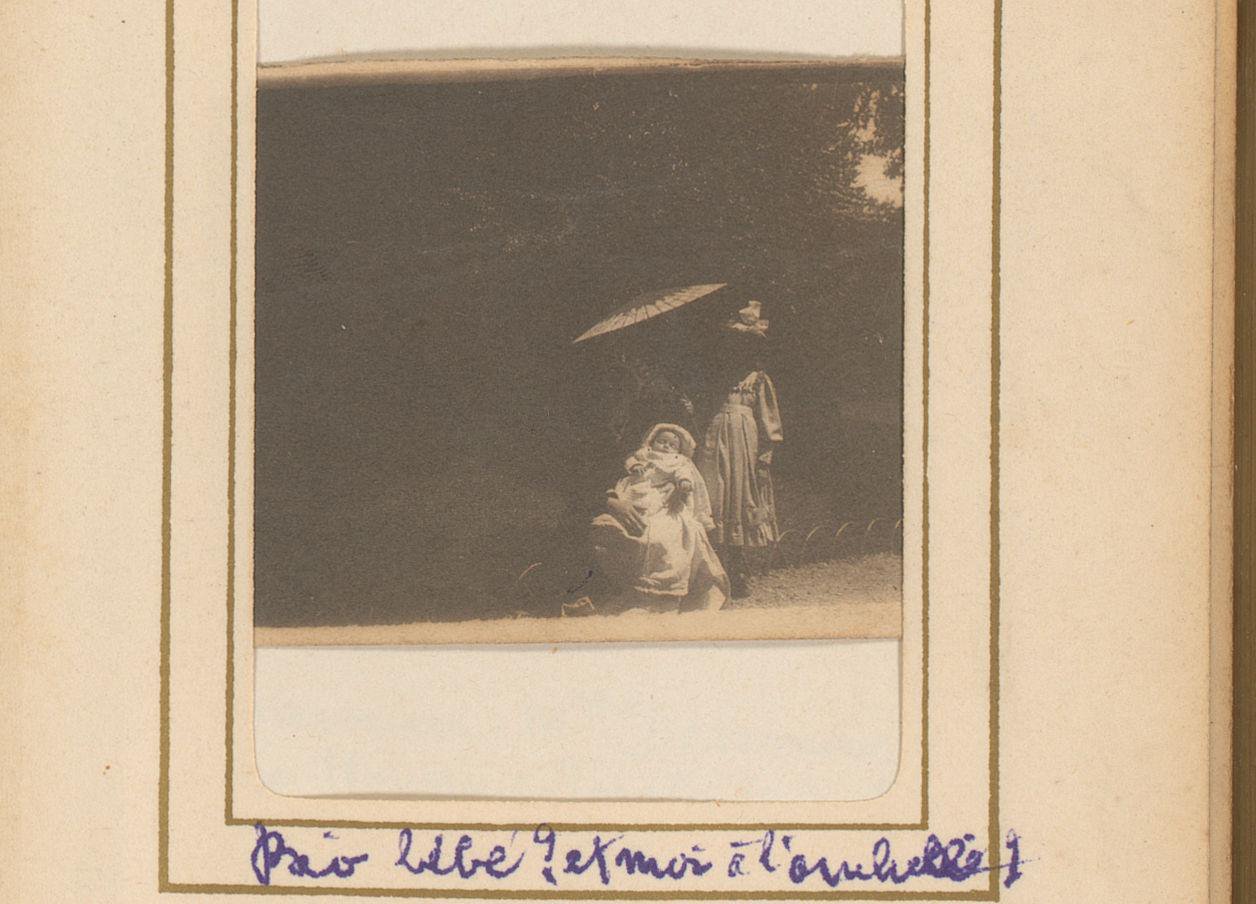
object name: photograph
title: Vrouwen met baby in een tuin of park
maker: Anonymous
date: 1870-1890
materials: photographic support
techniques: platinum process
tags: trees, historical persons, mother and child(ren), woman and child(ren) (family group)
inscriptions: inscription: ‘[...]’